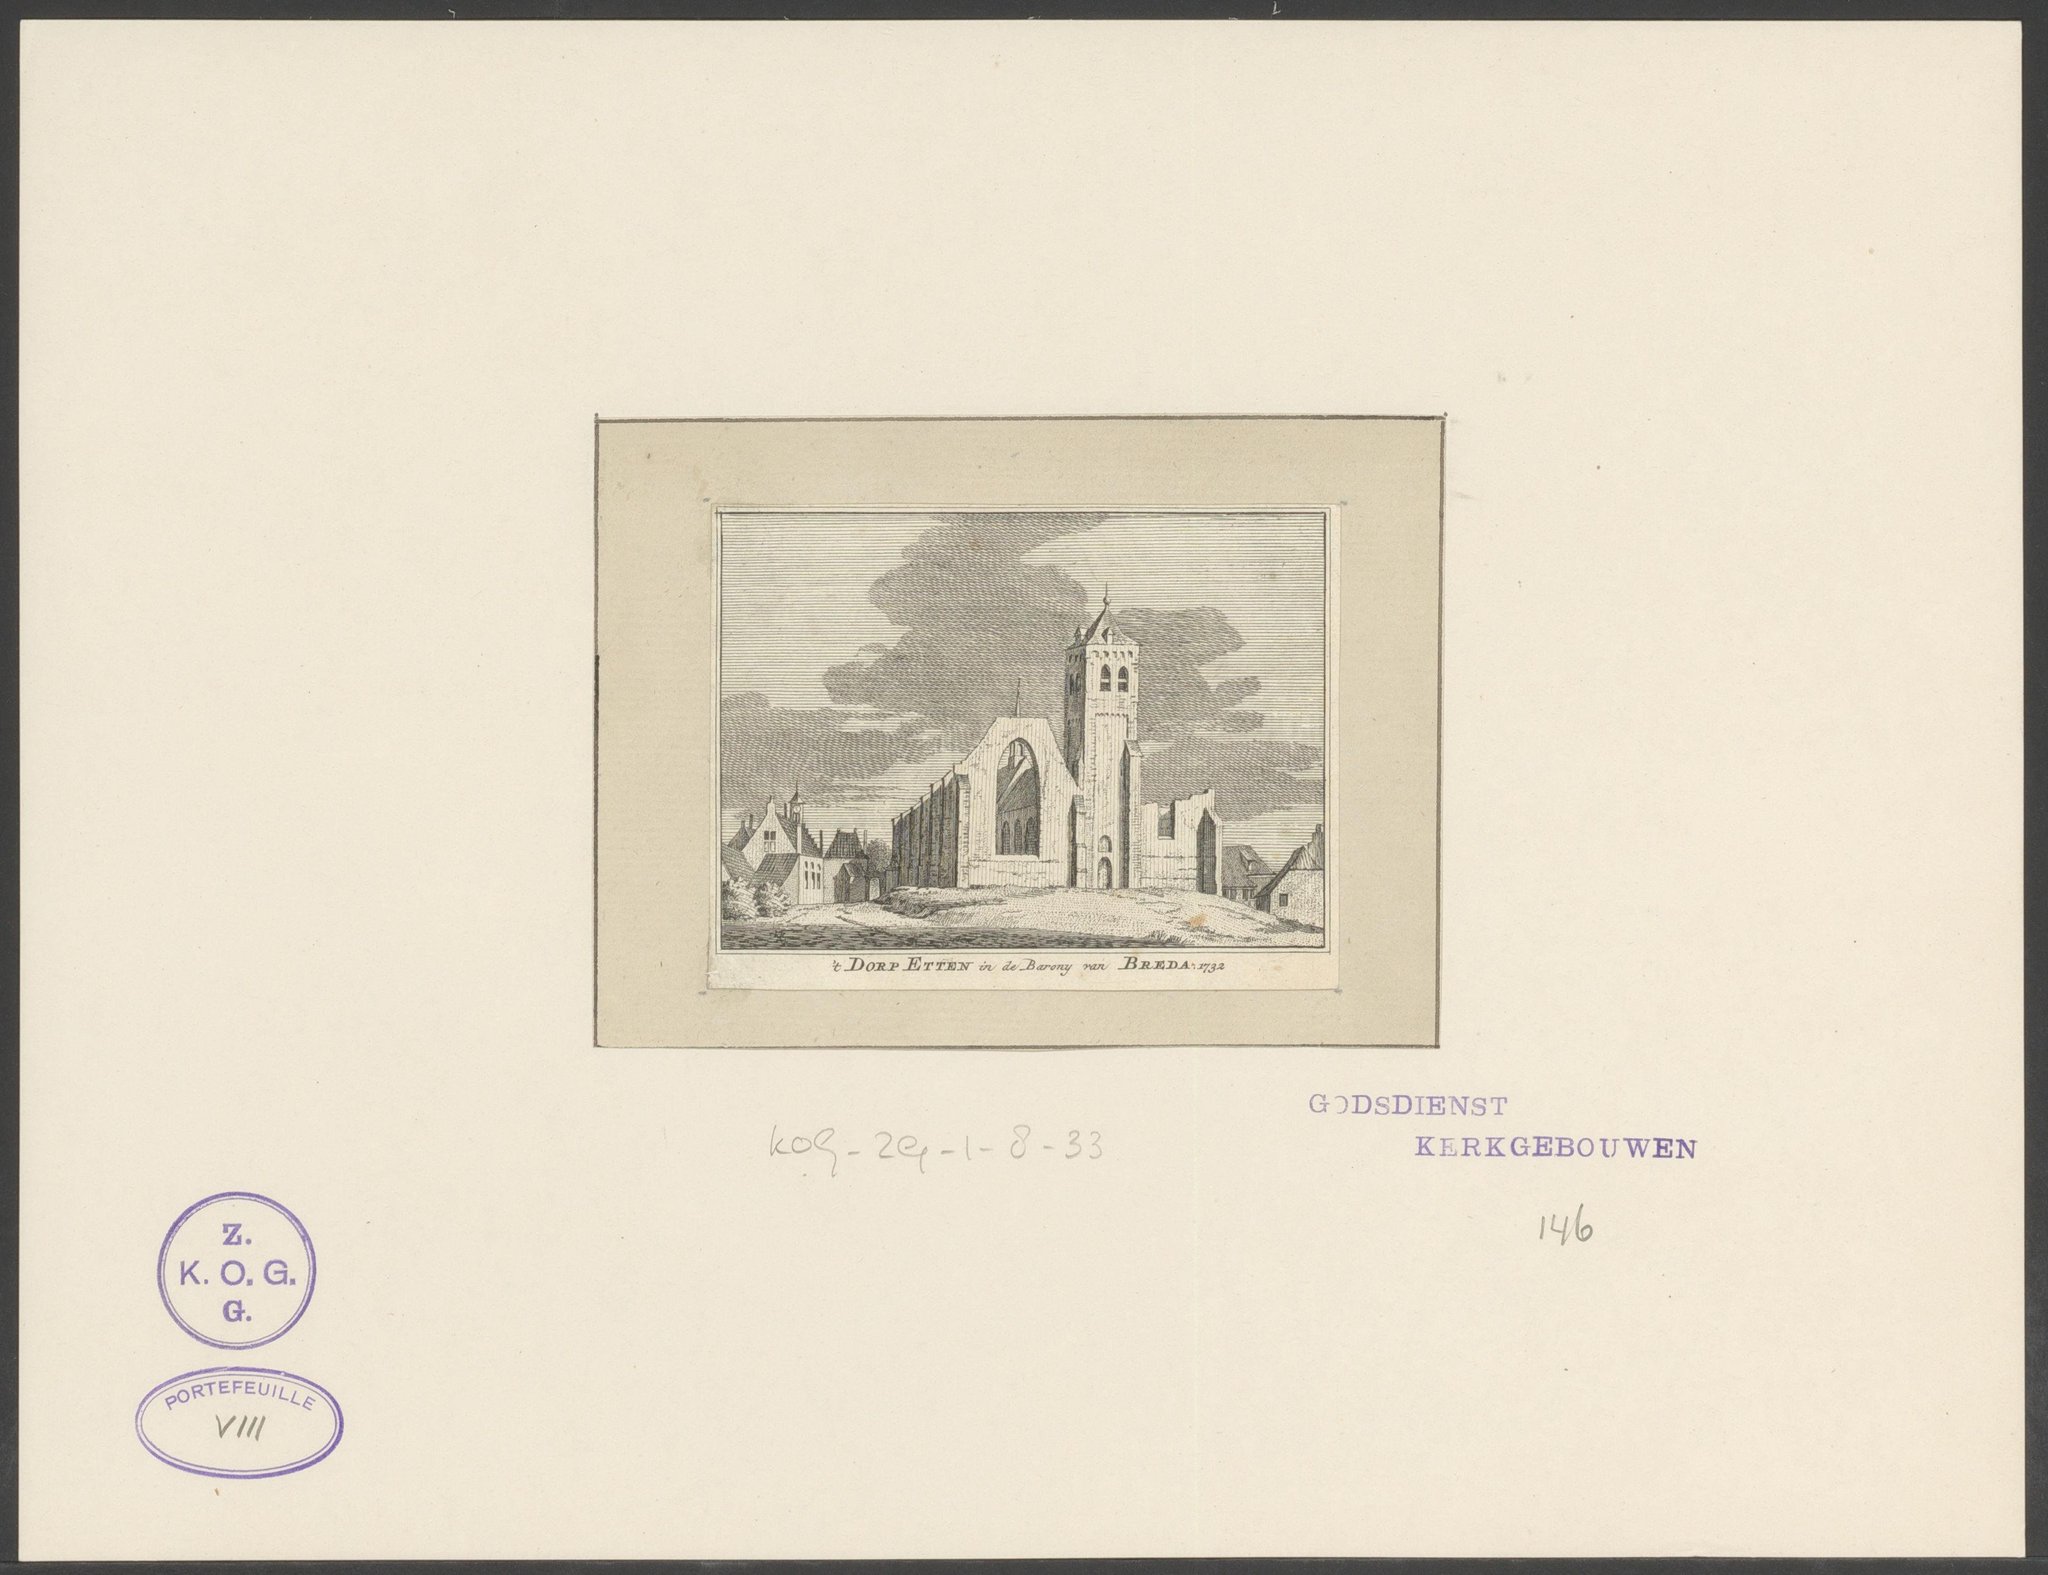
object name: book illustration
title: 't Dorp Etten in de Barony van Breda. 1732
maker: hendrik spilman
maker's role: draughtsman, painter, print maker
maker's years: 1721-1784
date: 1746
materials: paper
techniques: engraving, etching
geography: netherlands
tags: church (exterior), ruin of church, monastery, etc.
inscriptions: collector's mark, collector's mark: Lugt 1641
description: Gezicht op de ruïne van een kerk in het dorp Etten, omstreeks 1732. Afgesneden bovenste deel van een plaat met twee voorstellingen. Onderwerpsrubrieken binnen de Atlas Zeden en Gewoonten: Kerk en kerkwezen & Armwezen en liefdadige instellingen; Kerkgebouwen elders. A-E.